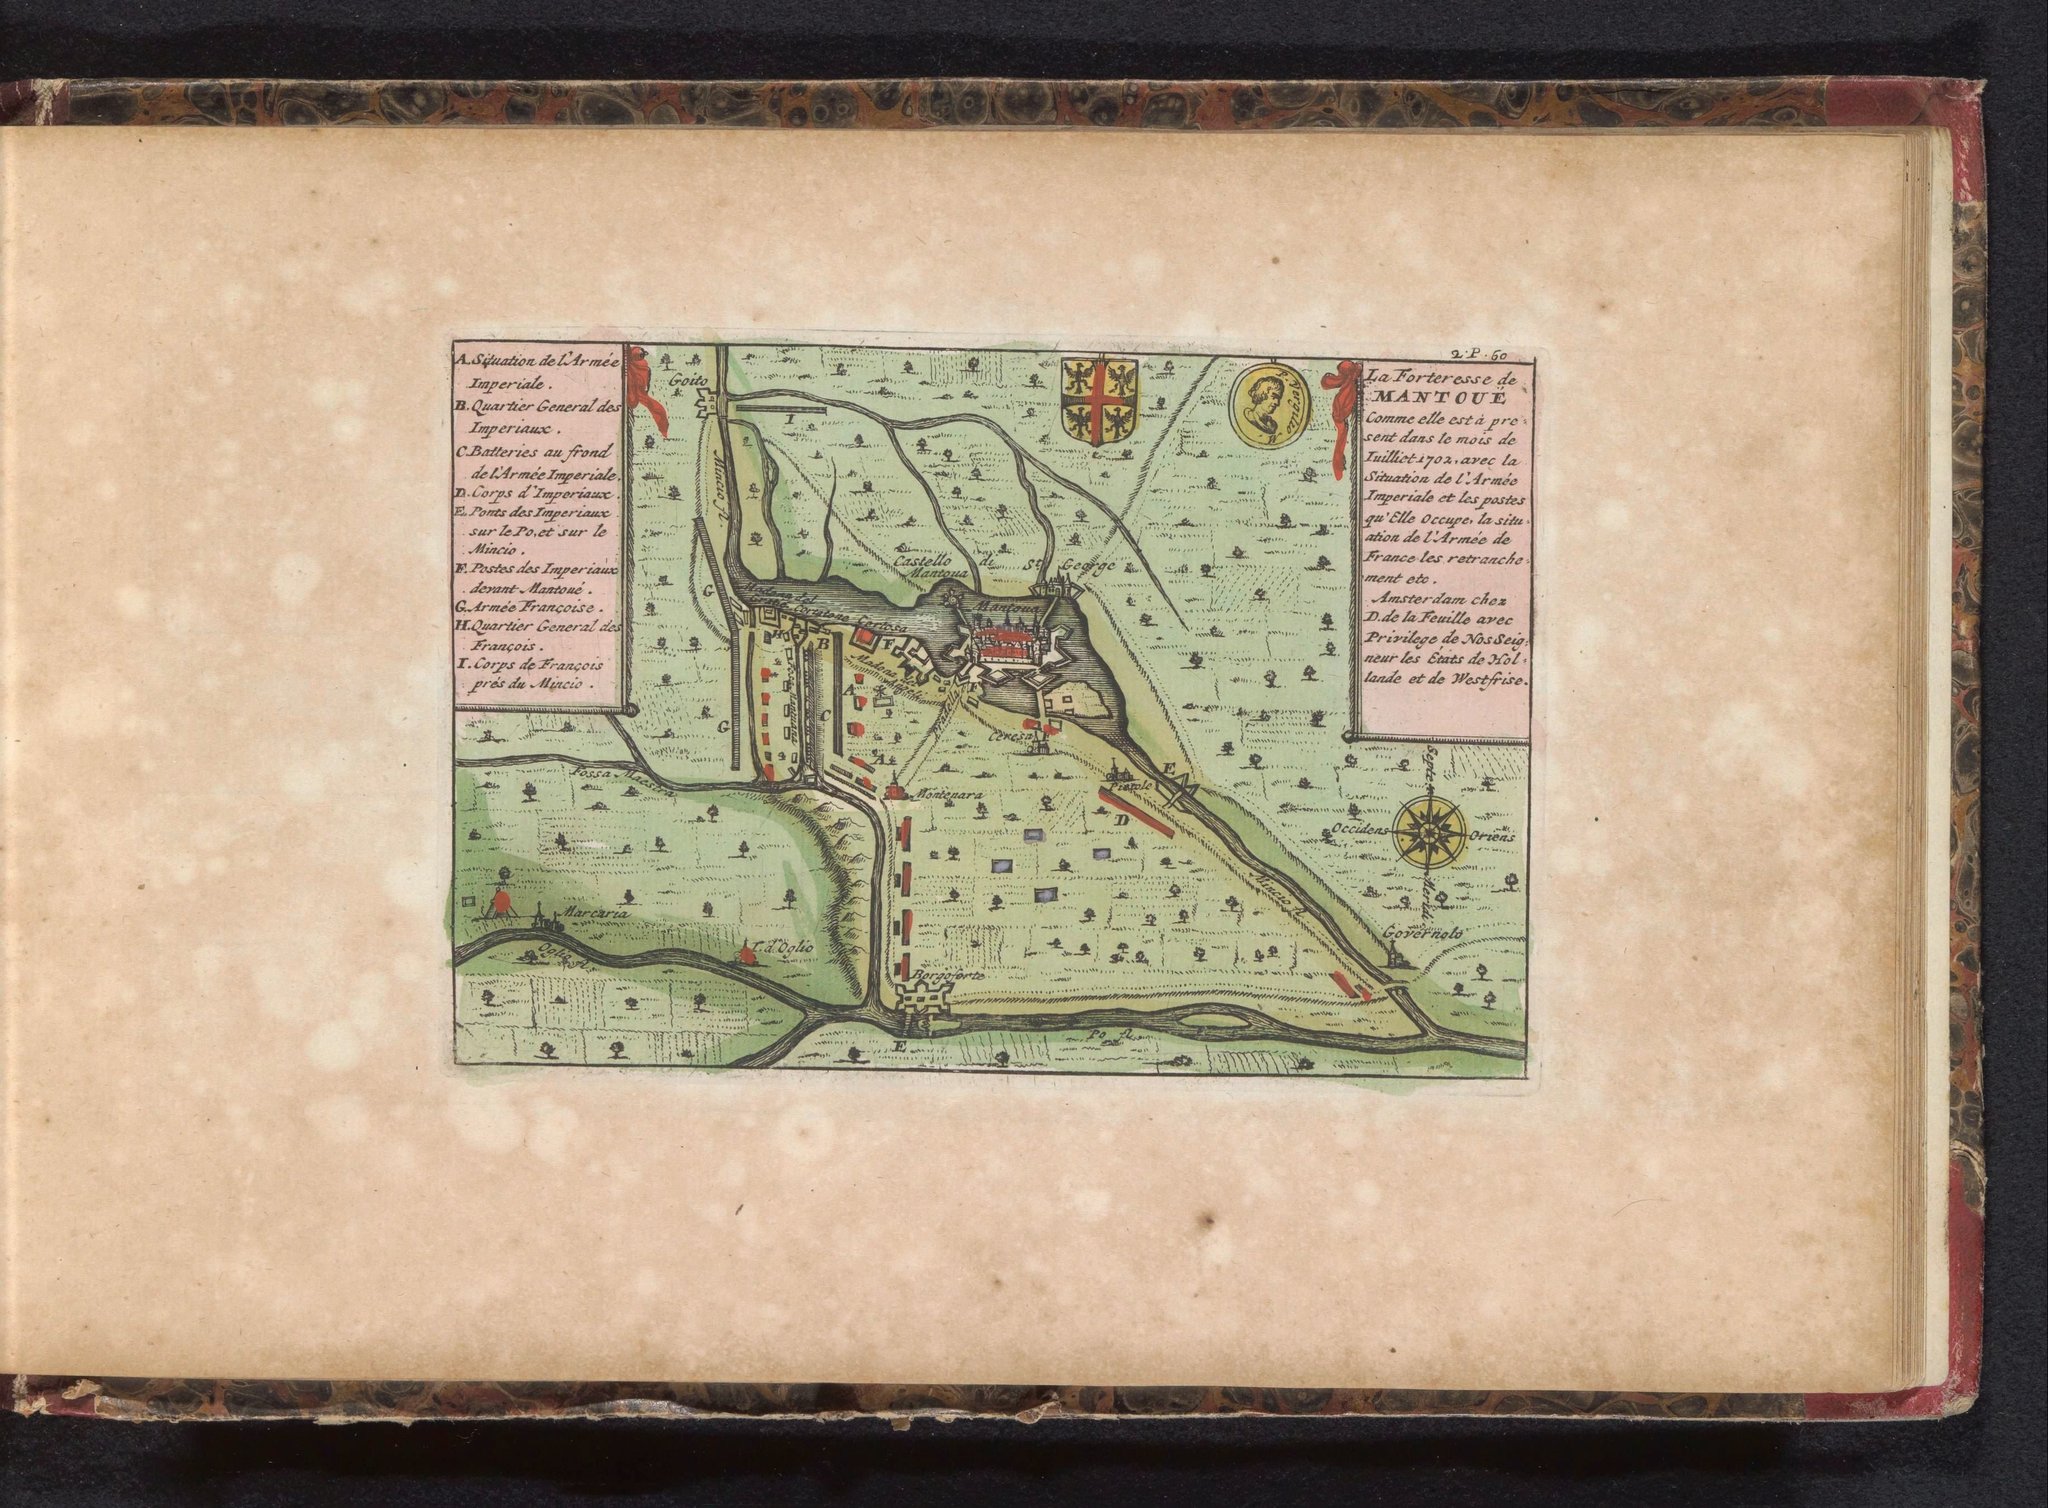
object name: map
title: La Forteresse de Mantoué Comme elle est à present dans le mois de Iuillet 1702, avec la situation de l'Armée Imperiale et les postes qu'Elle Occupe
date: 1700-1702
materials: paper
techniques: etching, hand coloring, lacquer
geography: amsterdam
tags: maps of cities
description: Kaart van de stad Matua met de ligging van de Geallieerden en de Franse troepen in juli 1702. Onderdeel van een atlas met 223 kaarten van landen en steden en oorlogstaferelen in Europa in de periode ca. 1690-1735.